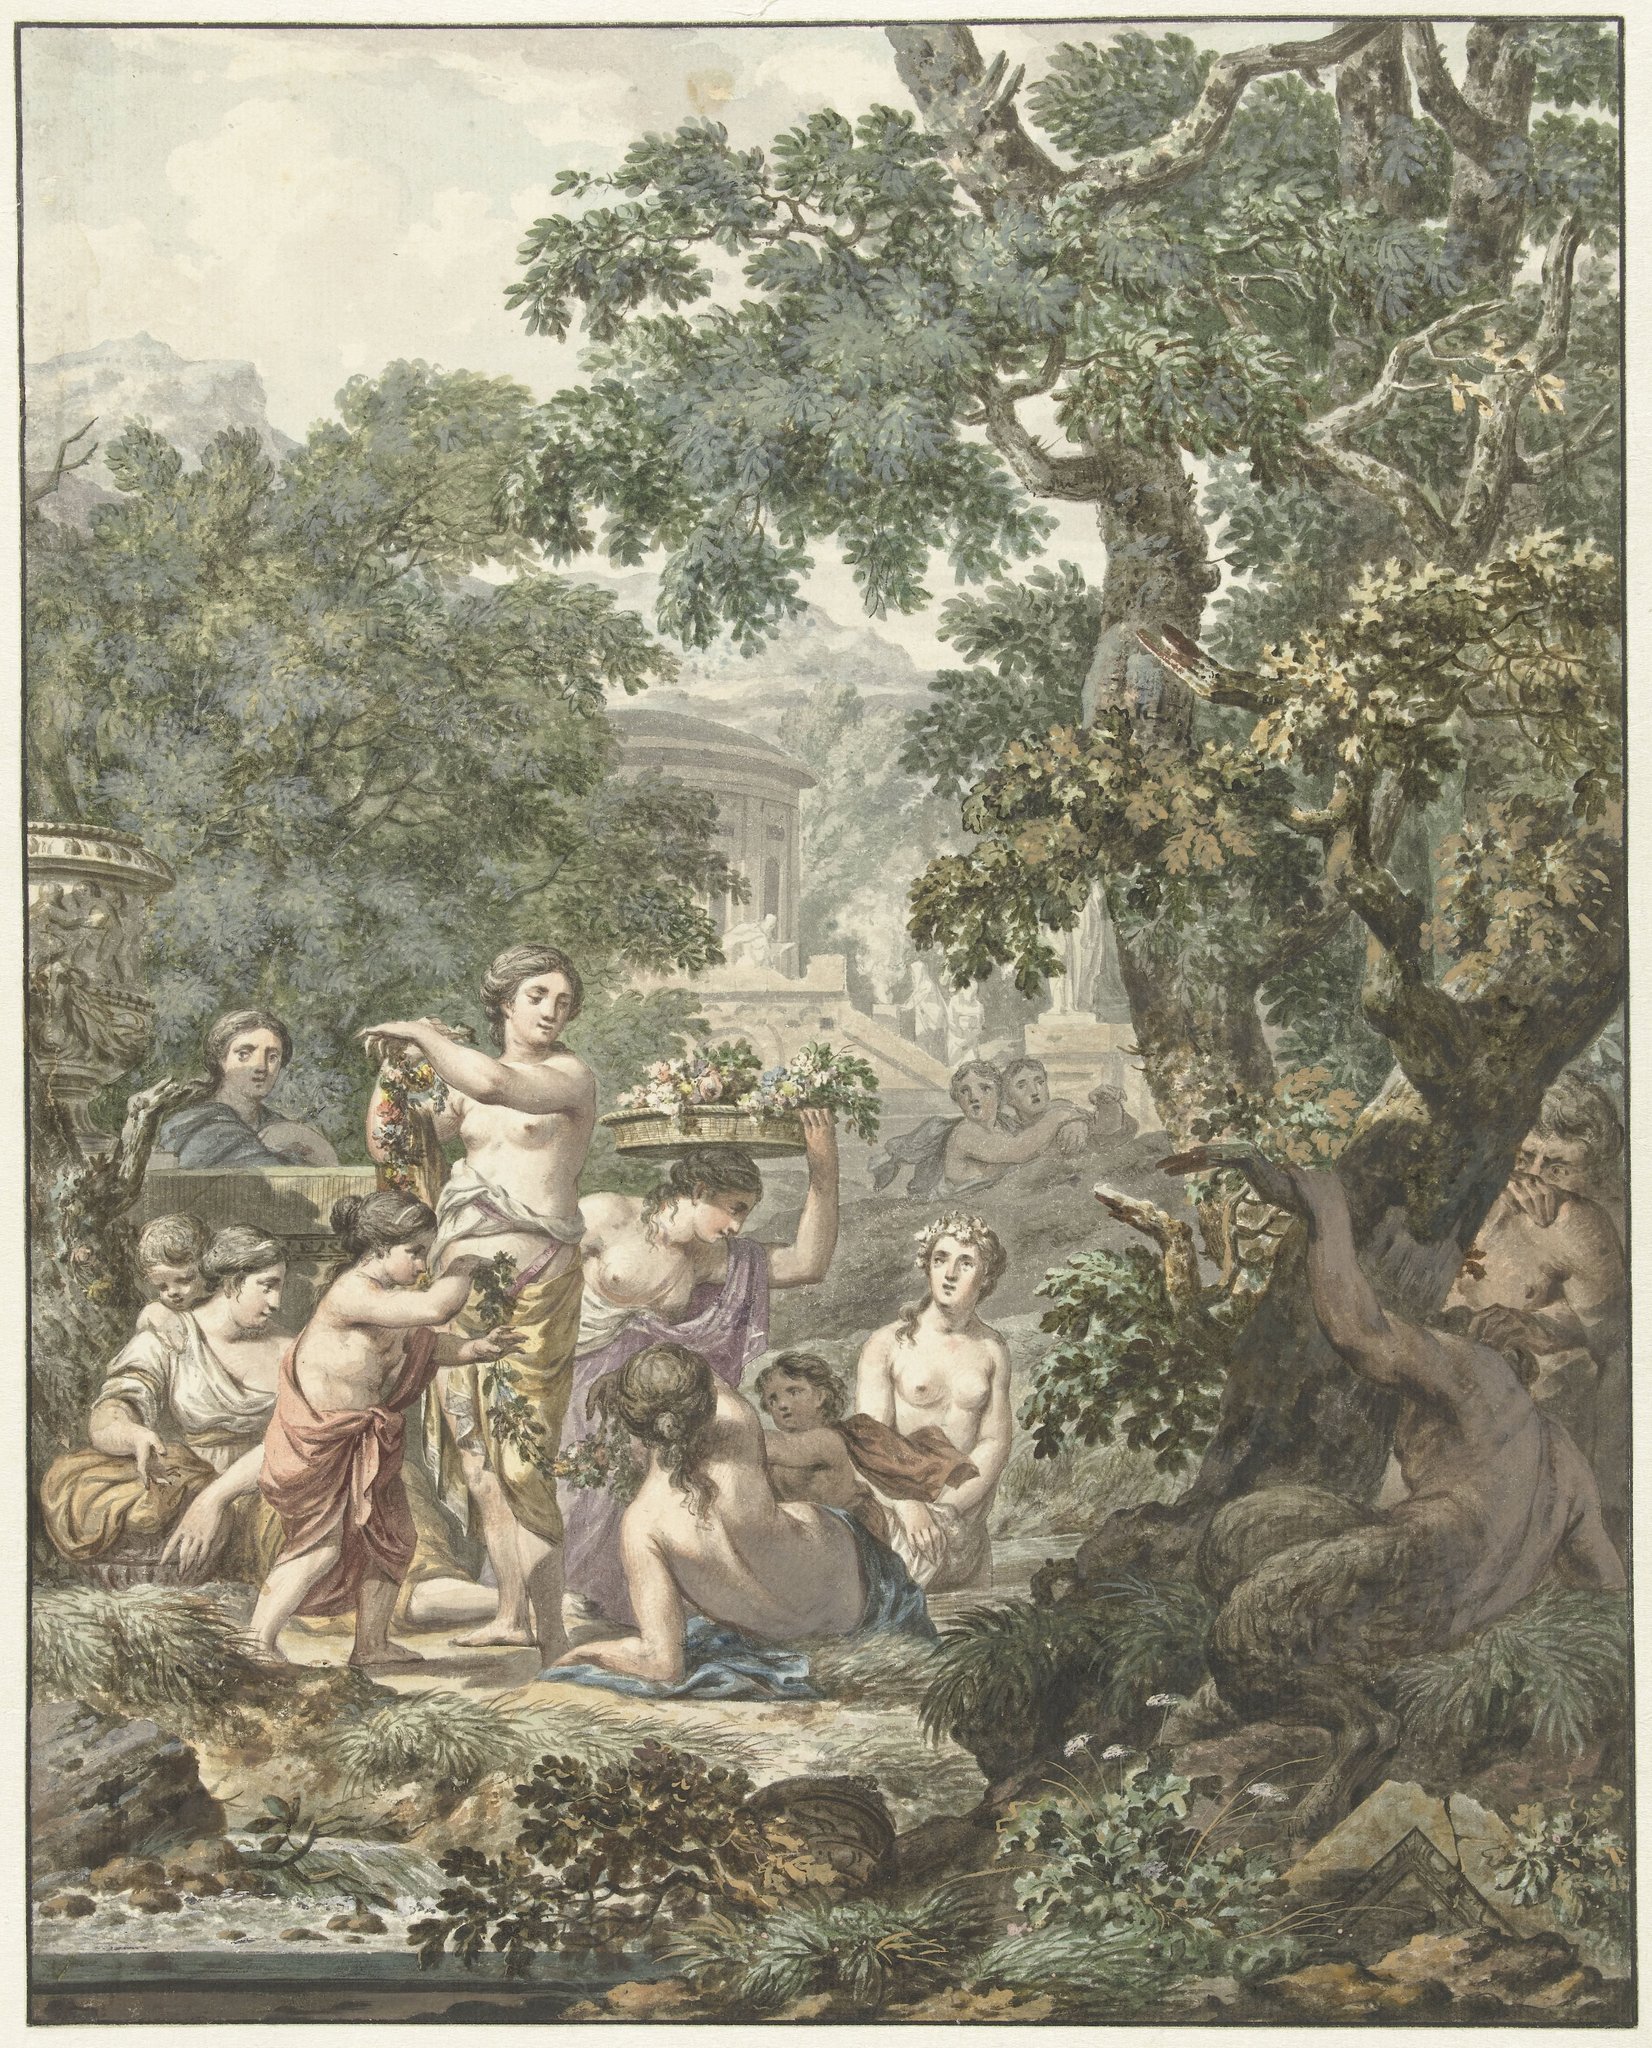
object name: drawing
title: Arcadisch landschap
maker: jean grandjean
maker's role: draughtsman, print maker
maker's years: 1752-1781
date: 1765-1781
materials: ink, paper, watercolor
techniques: brush, pen